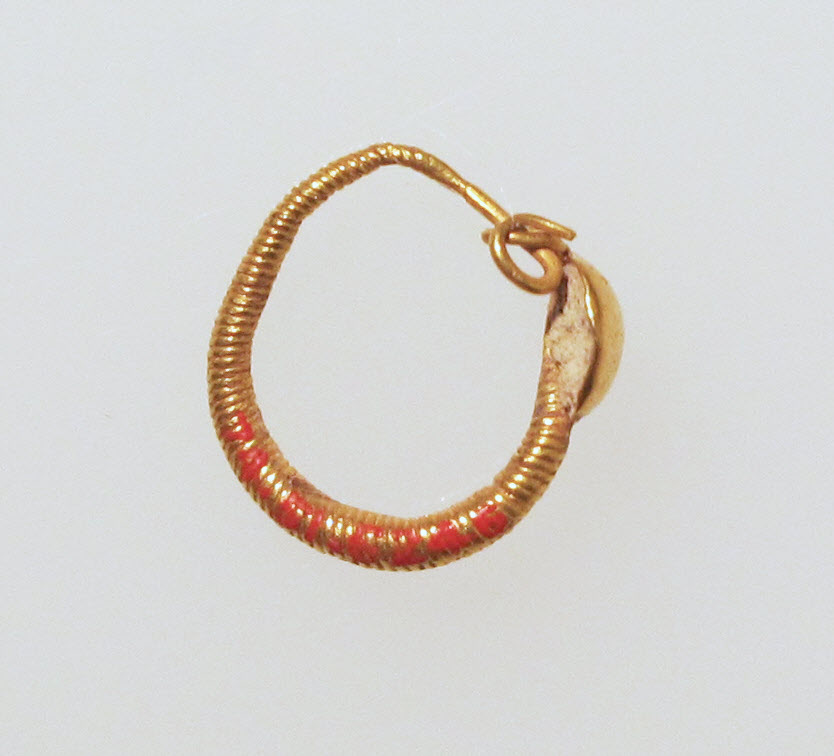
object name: earring with plain loop and disc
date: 7000 BCE-330 CE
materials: gold